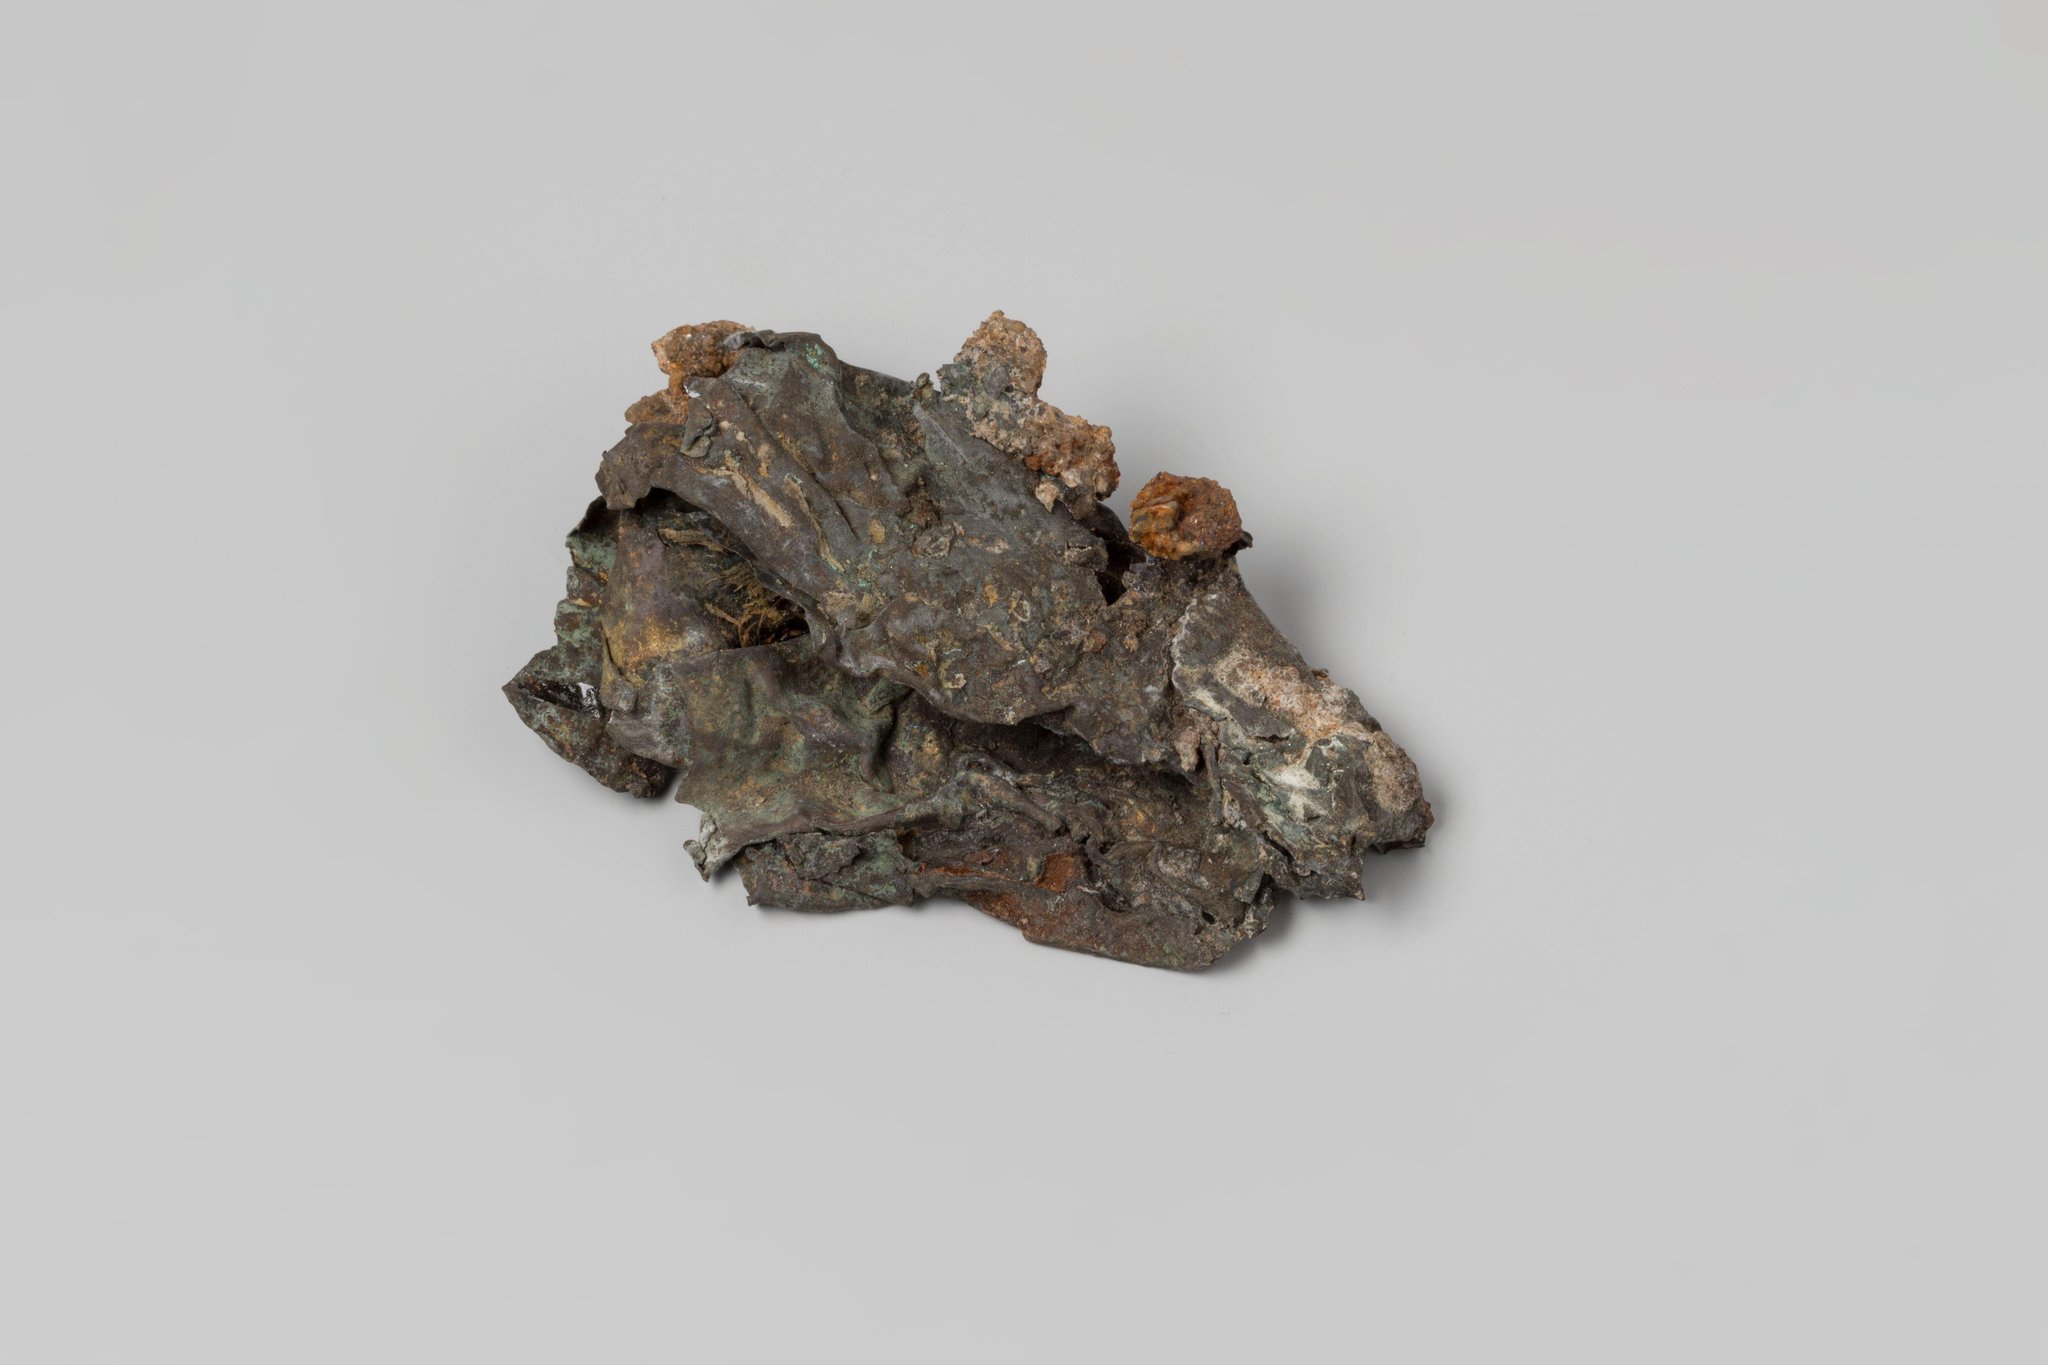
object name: fragment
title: Fragment plaatwerk uit het wrak van de Oost-Indiëvaarder Hollandia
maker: Anonymous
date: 1700-1743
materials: copper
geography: netherlands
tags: verenigde oostindische compagnie, hollandia (schip), annet